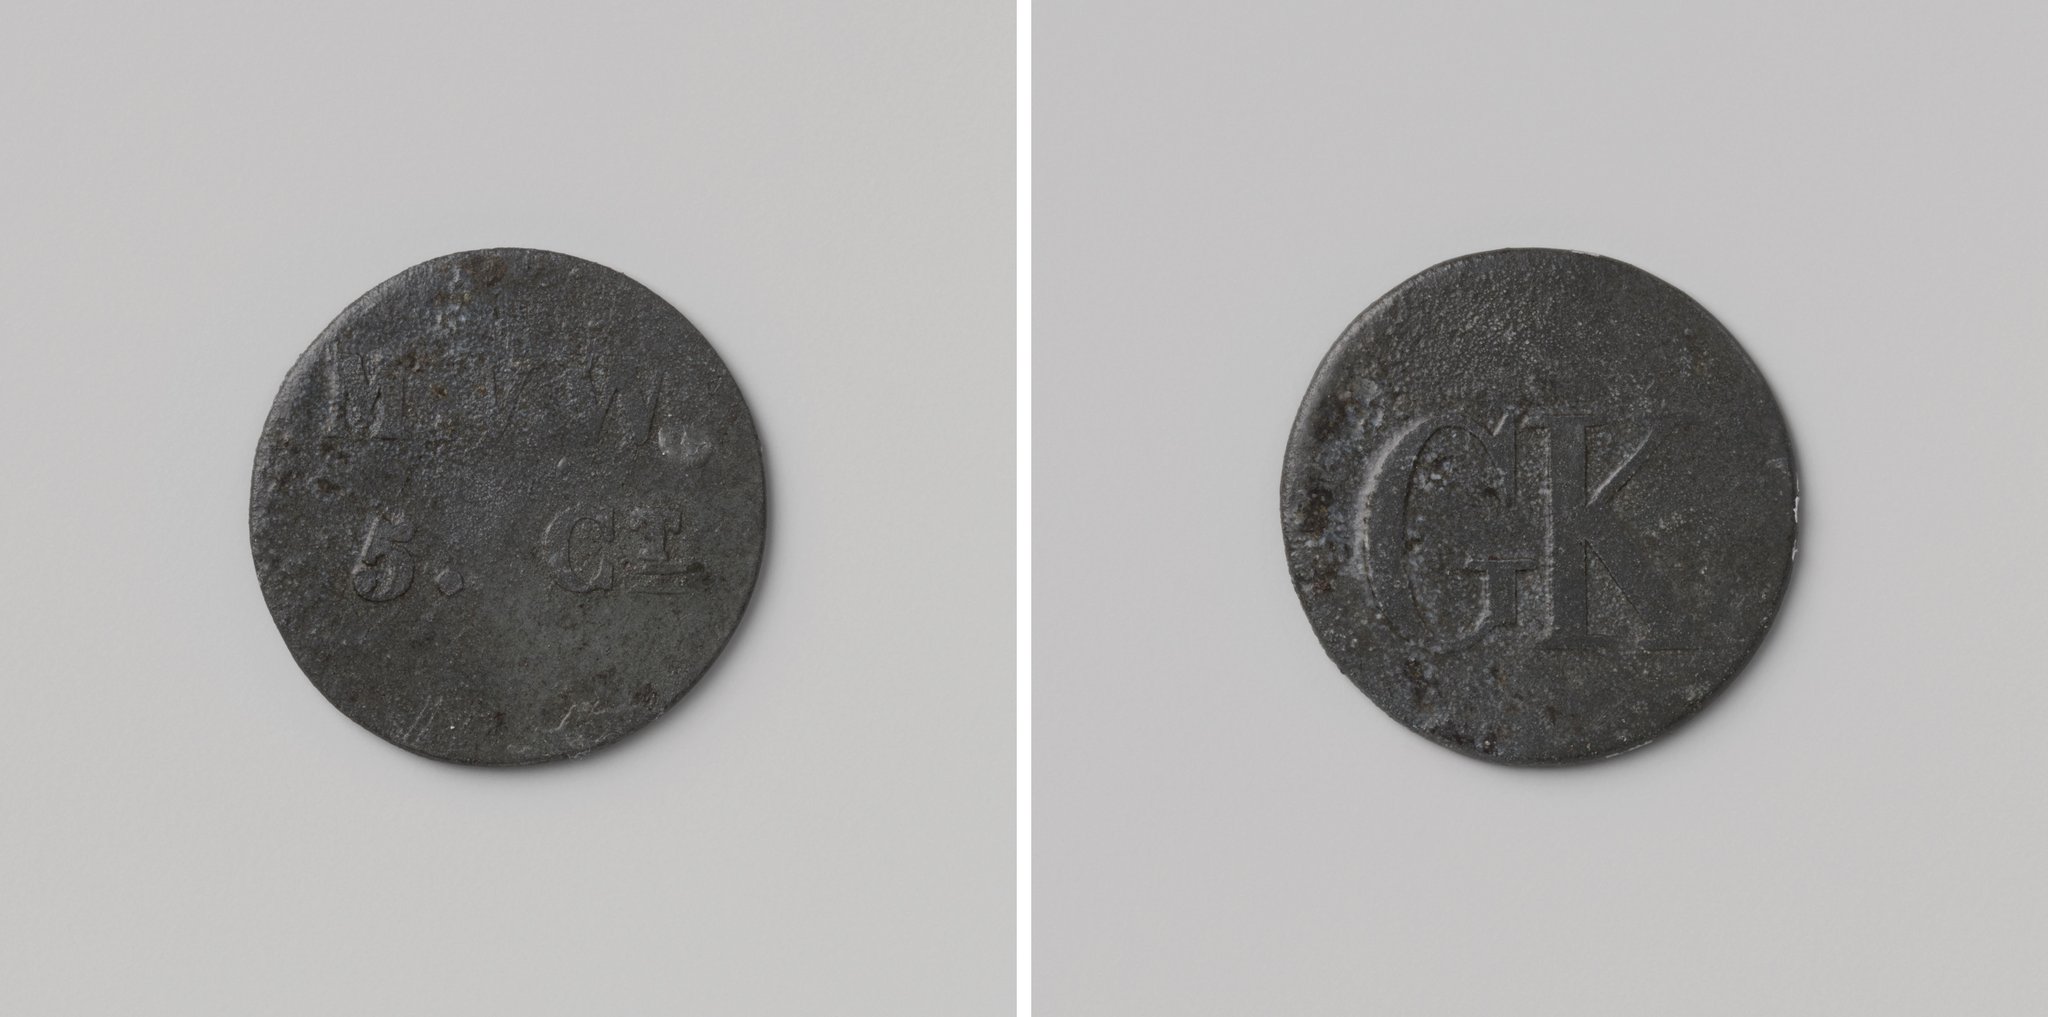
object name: monetary token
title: Huismunt geslagen op last van de Maatschappij van Weldadigheid ter waarde van vijf cent, ten behoeve van de Gewone Koloniën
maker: Anonymous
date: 1818-1859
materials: zinc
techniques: striking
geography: netherlands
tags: maatschappij van weldadigheid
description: Zinken munt. Voorzijde: opschrift boven waardeaanduiding. Keerzijde: opschrift G en K.